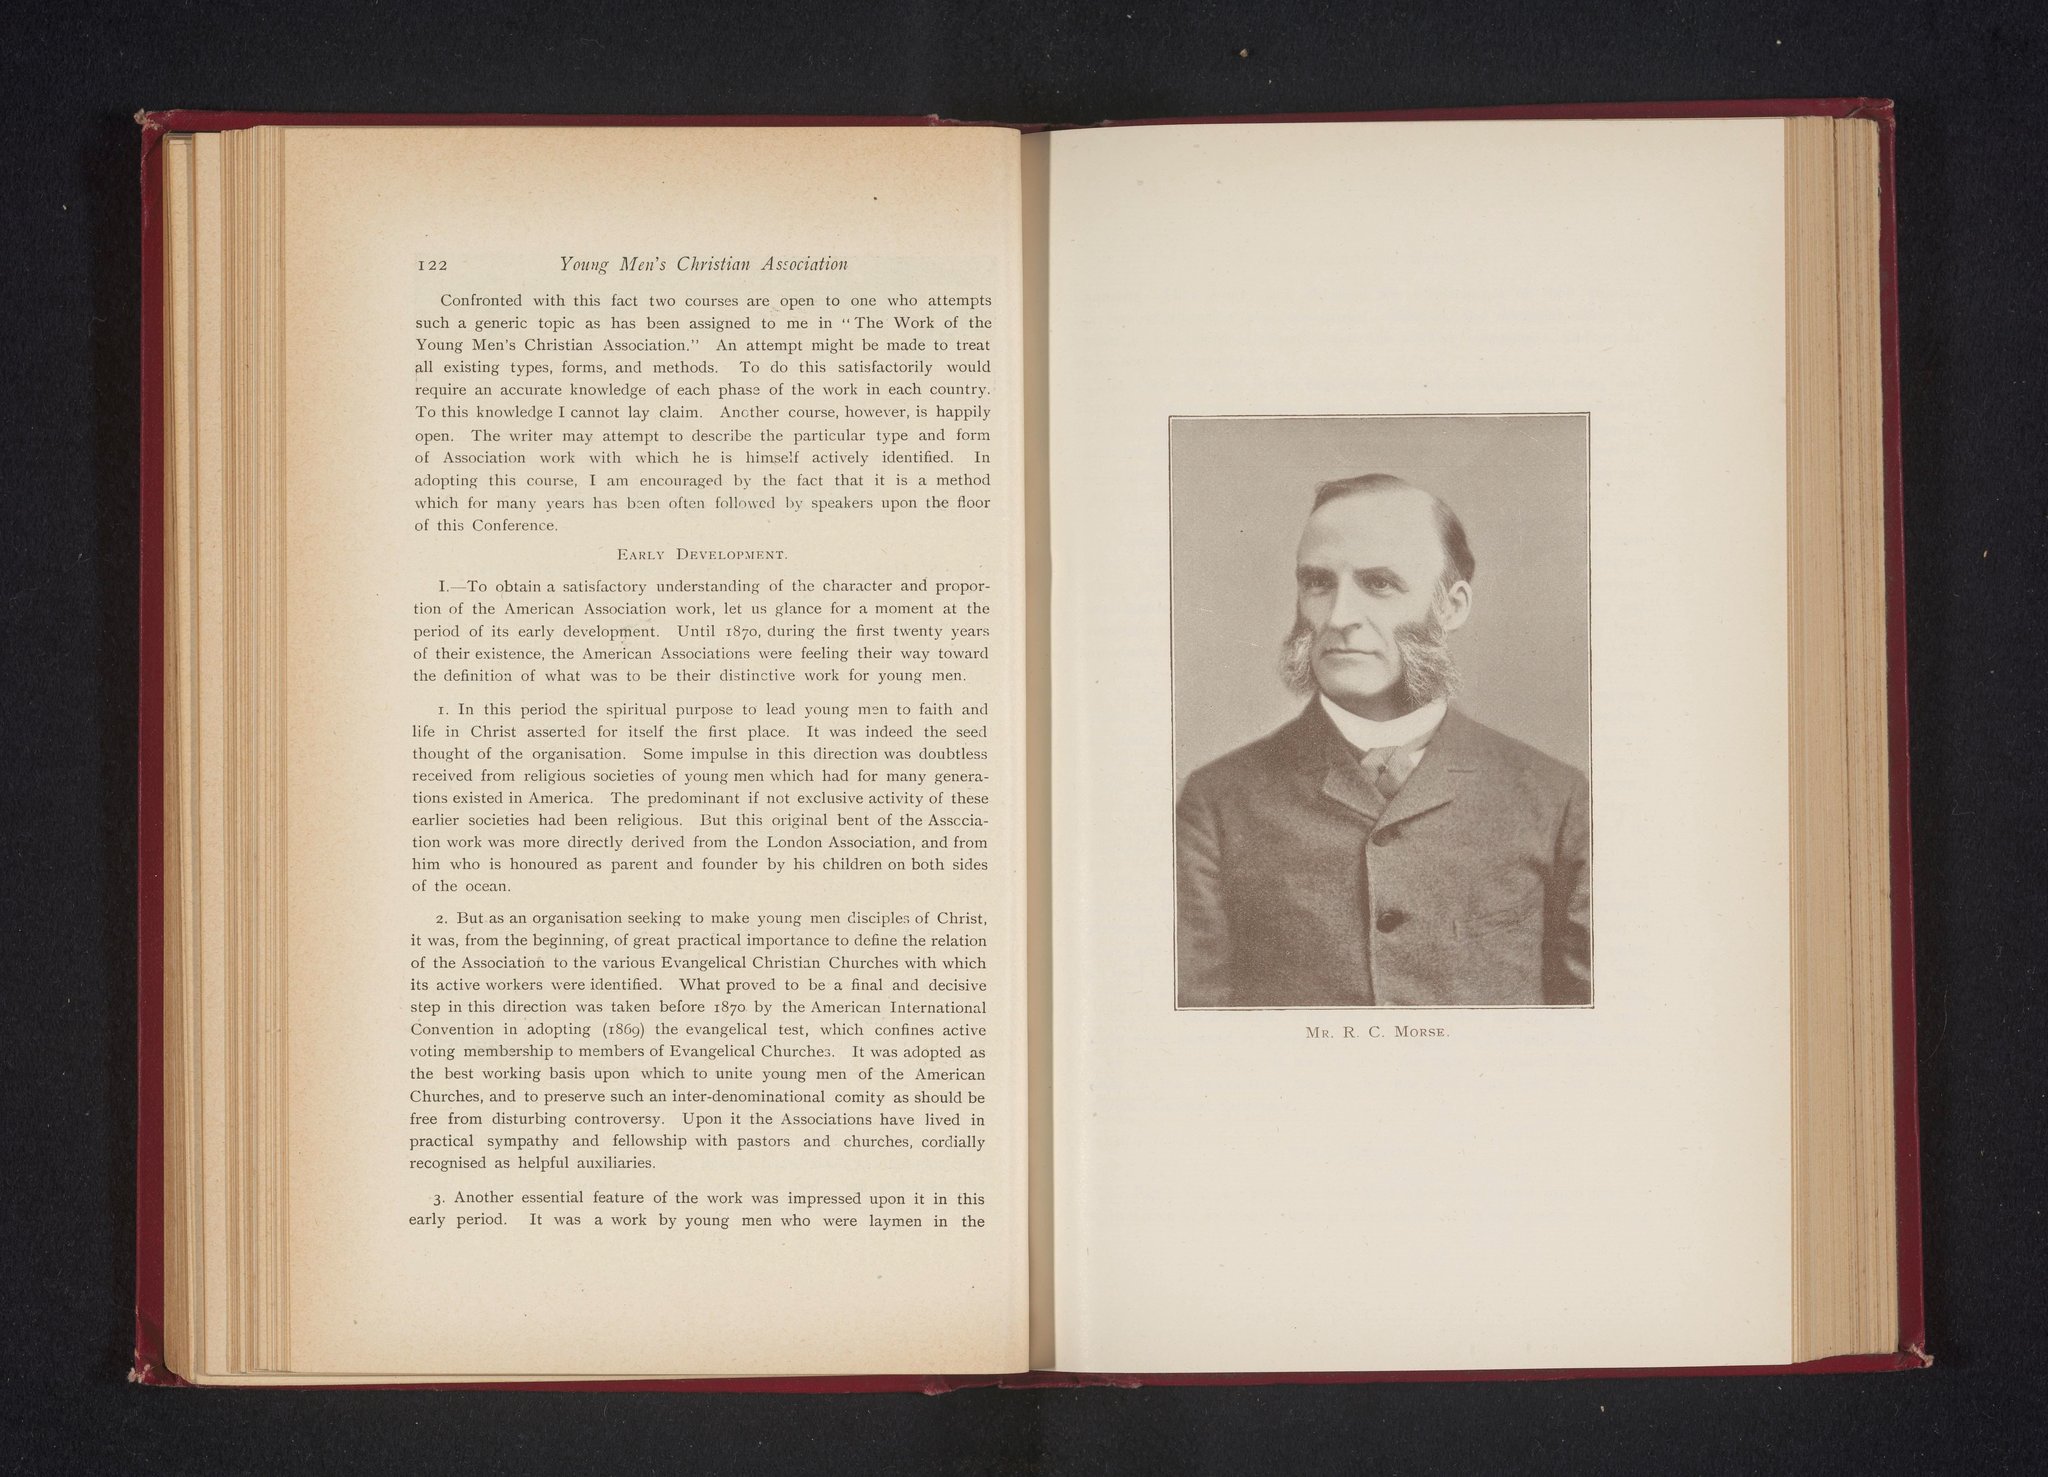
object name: photomechanical print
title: Mr. R. C. Morse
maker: Anonymous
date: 1890-1895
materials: paper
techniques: autotype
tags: historical persons